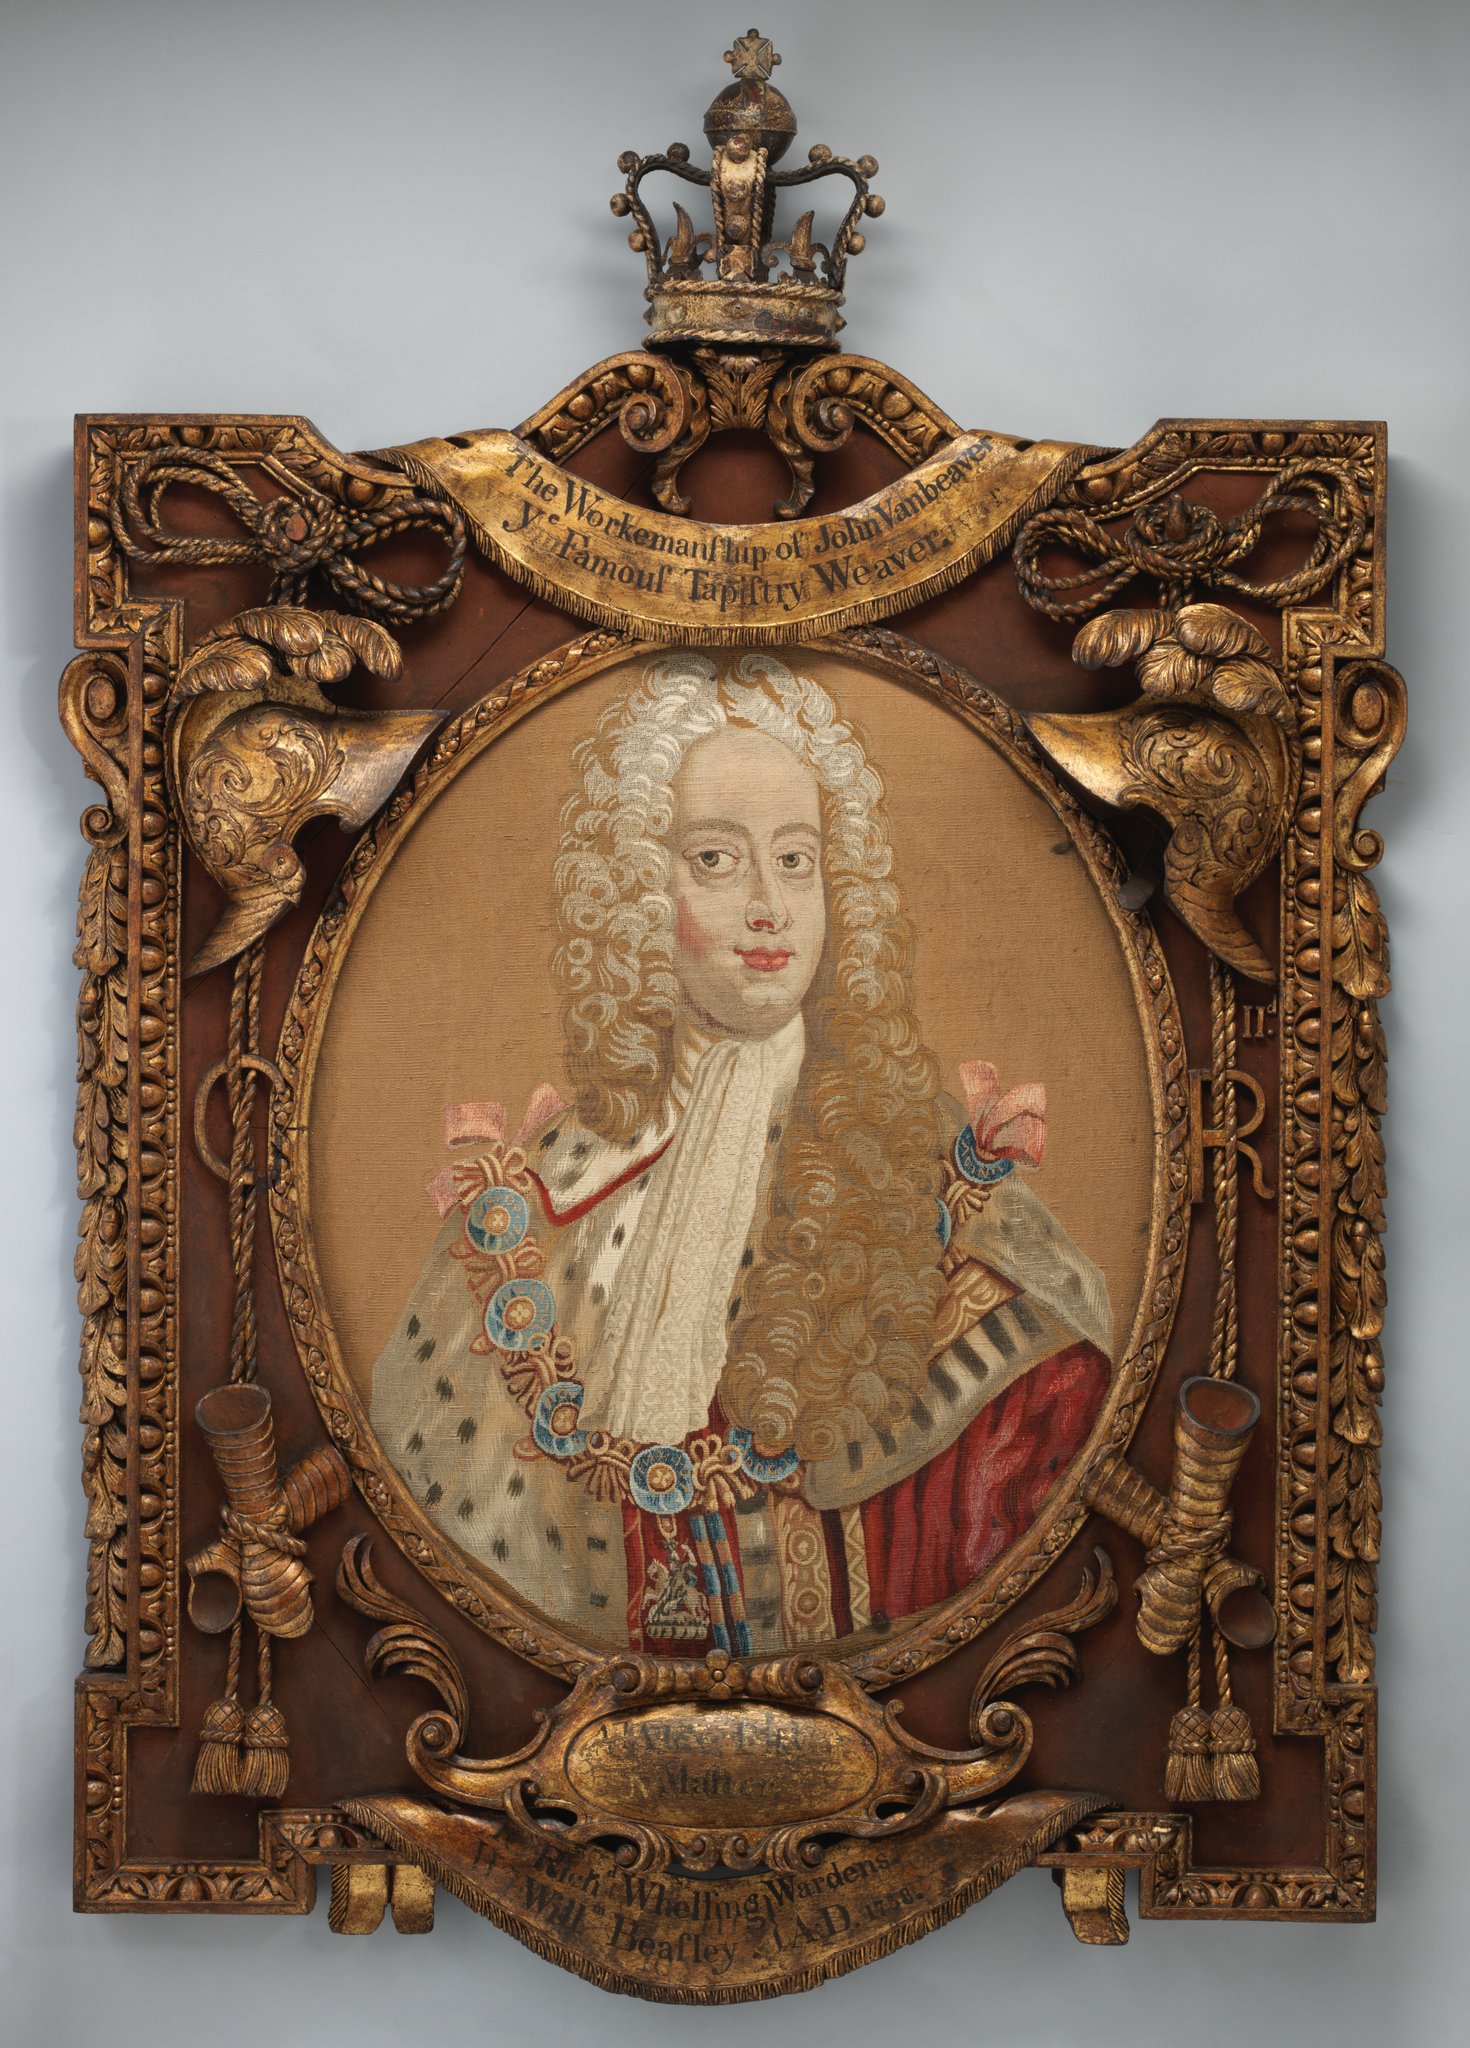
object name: tapestry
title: King George II (1683–1760)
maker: john van beaver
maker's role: maker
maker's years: 1727-1750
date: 1732-1735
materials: silk, wood, wool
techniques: carving, gilding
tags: kings,men,portraits